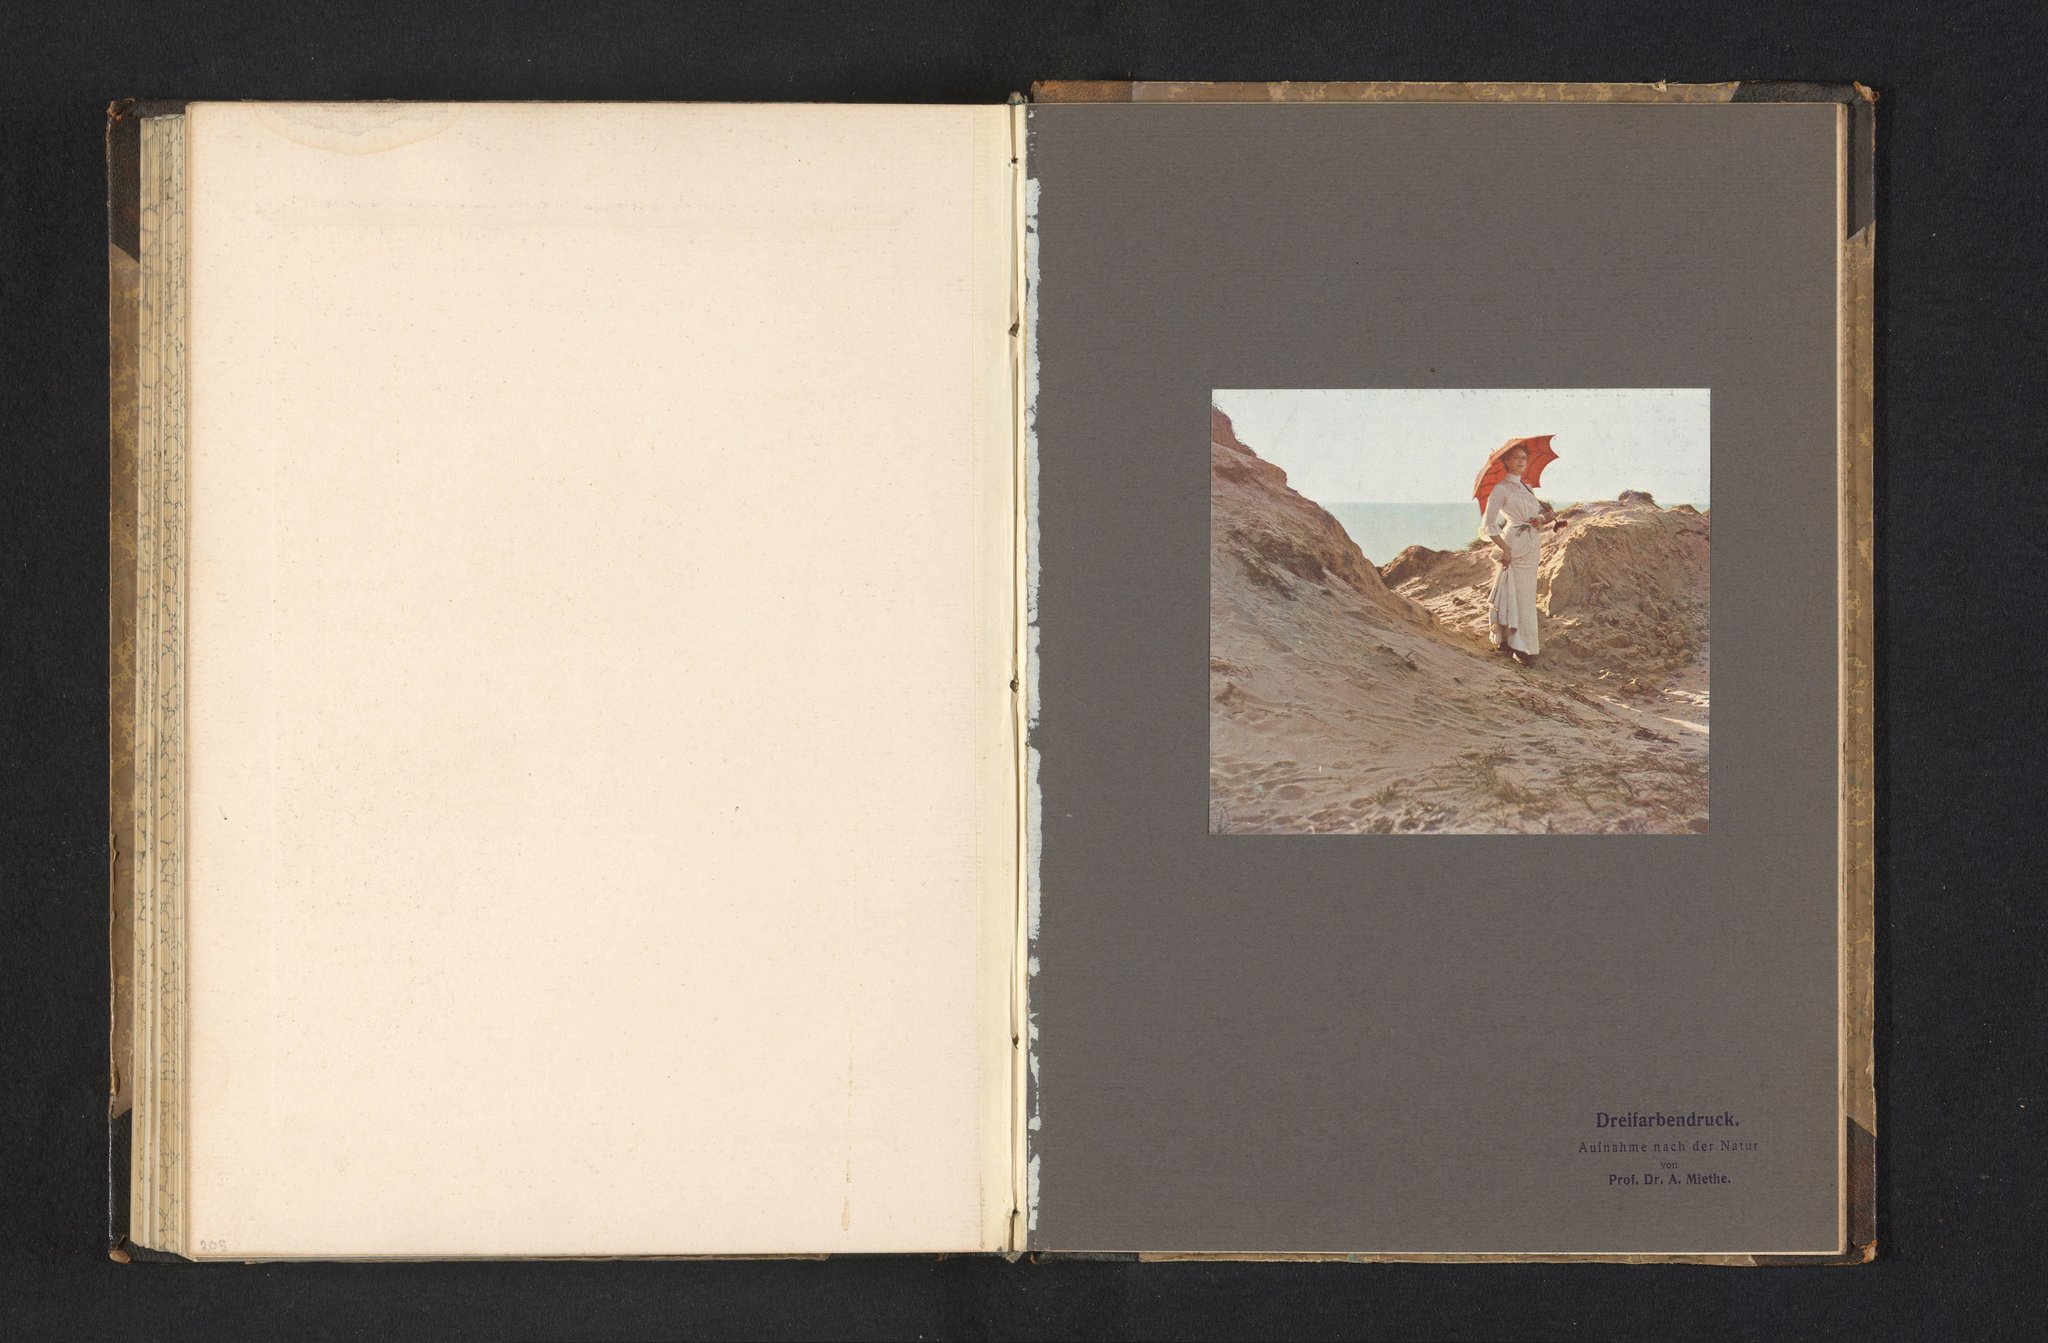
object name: photomechanical print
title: Vrouw met parasol in de duinen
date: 1898-1903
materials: paper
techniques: three-color autotype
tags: dune coast, adult woman, parasol, sunshade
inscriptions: inscription: ‘Dreifarbendruck./ Aufnahme nach der Natur/ von/ Prof. Dr. A. Miethe.’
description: Prent zeven van veertien prenten achterin het boek.